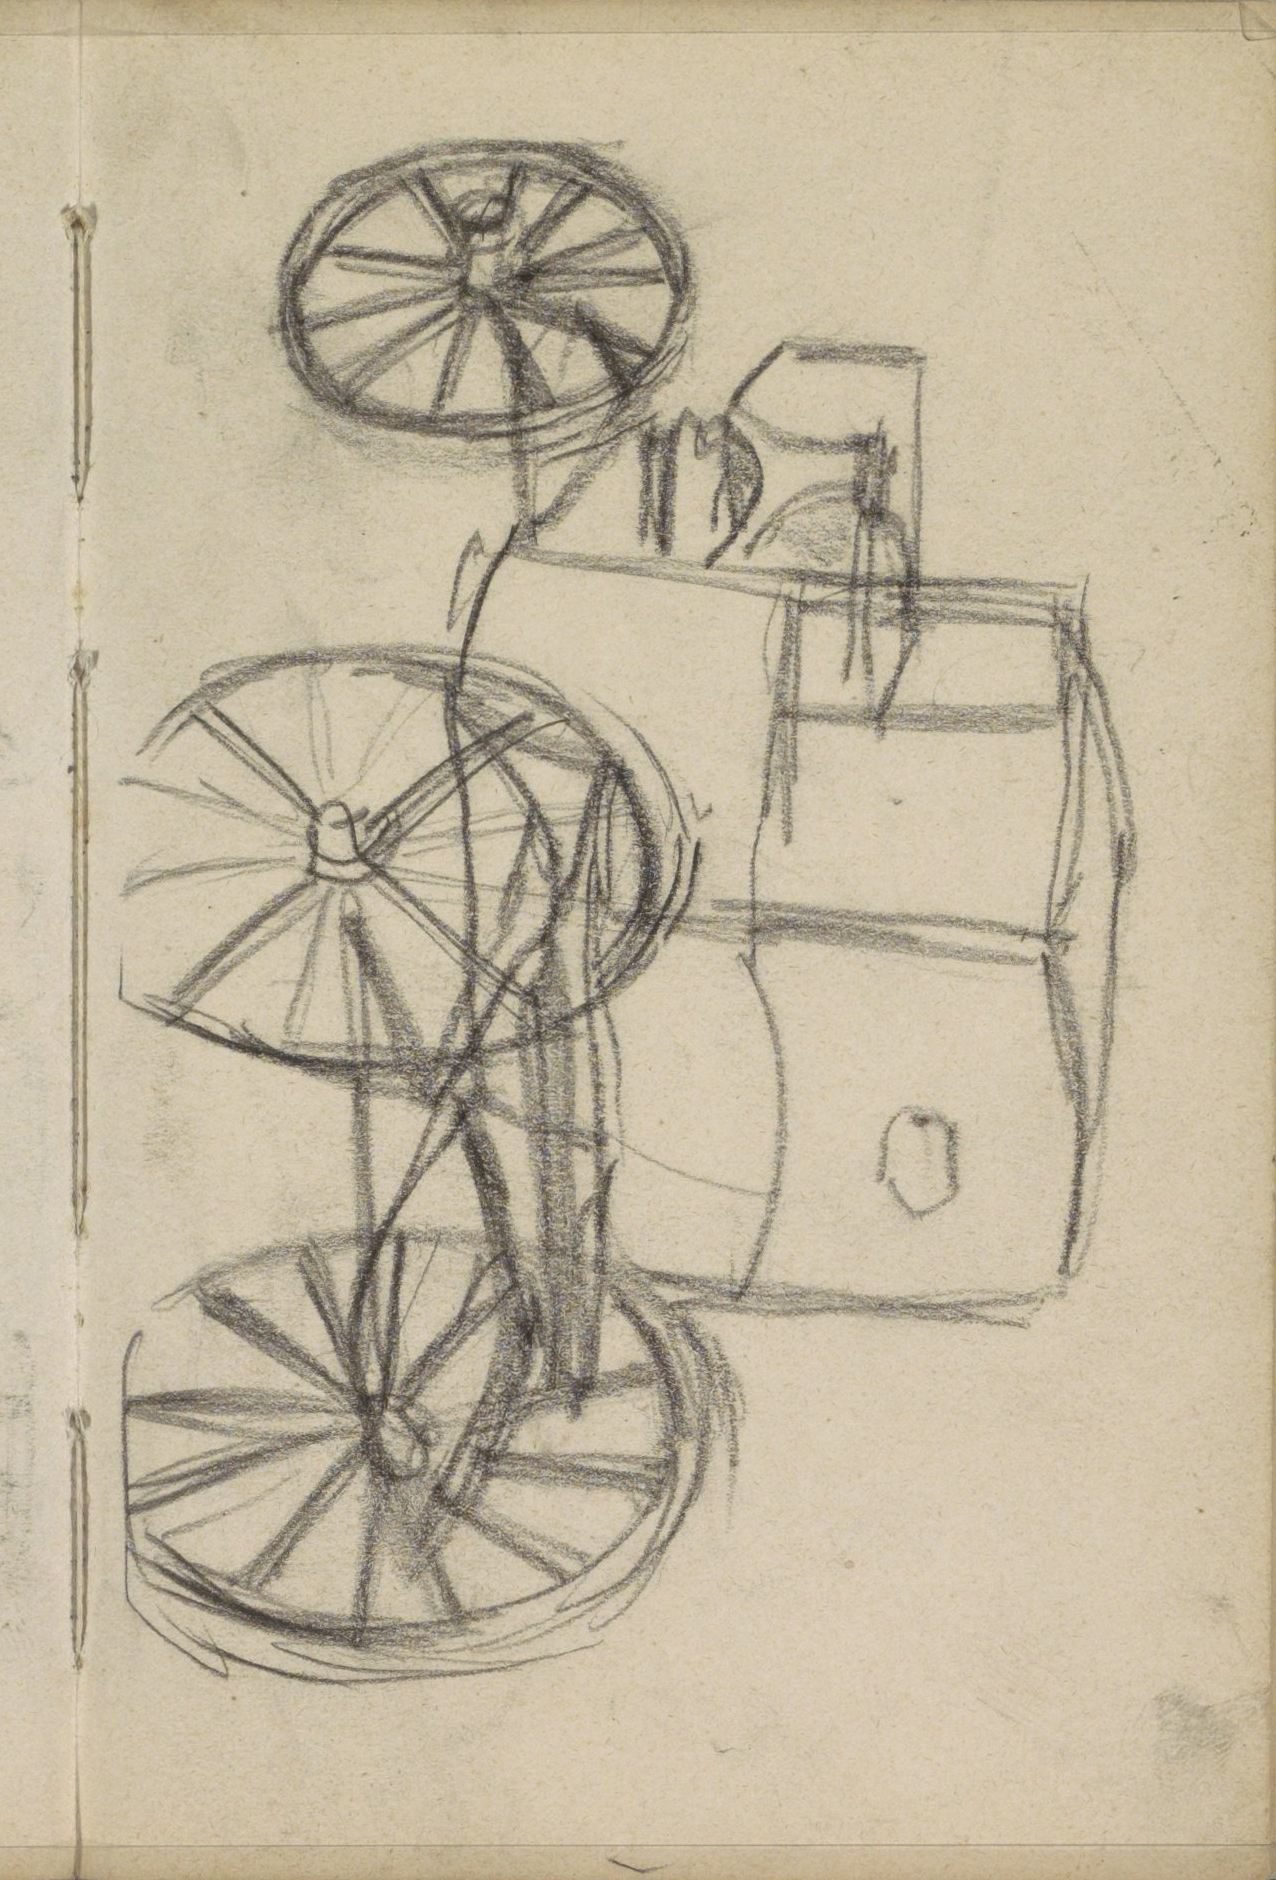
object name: sketchbook leaf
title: Rijtuig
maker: george hendrik breitner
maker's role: draughtsman, painter, print maker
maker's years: 1857-1923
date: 1902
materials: chalk, paper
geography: amsterdam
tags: four-wheeled, animal-drawn vehicle, e.g.: cab, carriage, coach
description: Pagina 60 uit een schetsboek met 46 bladen vervaardigd in de omgeving van Amsterdam, Rotterdam en Haarlem.